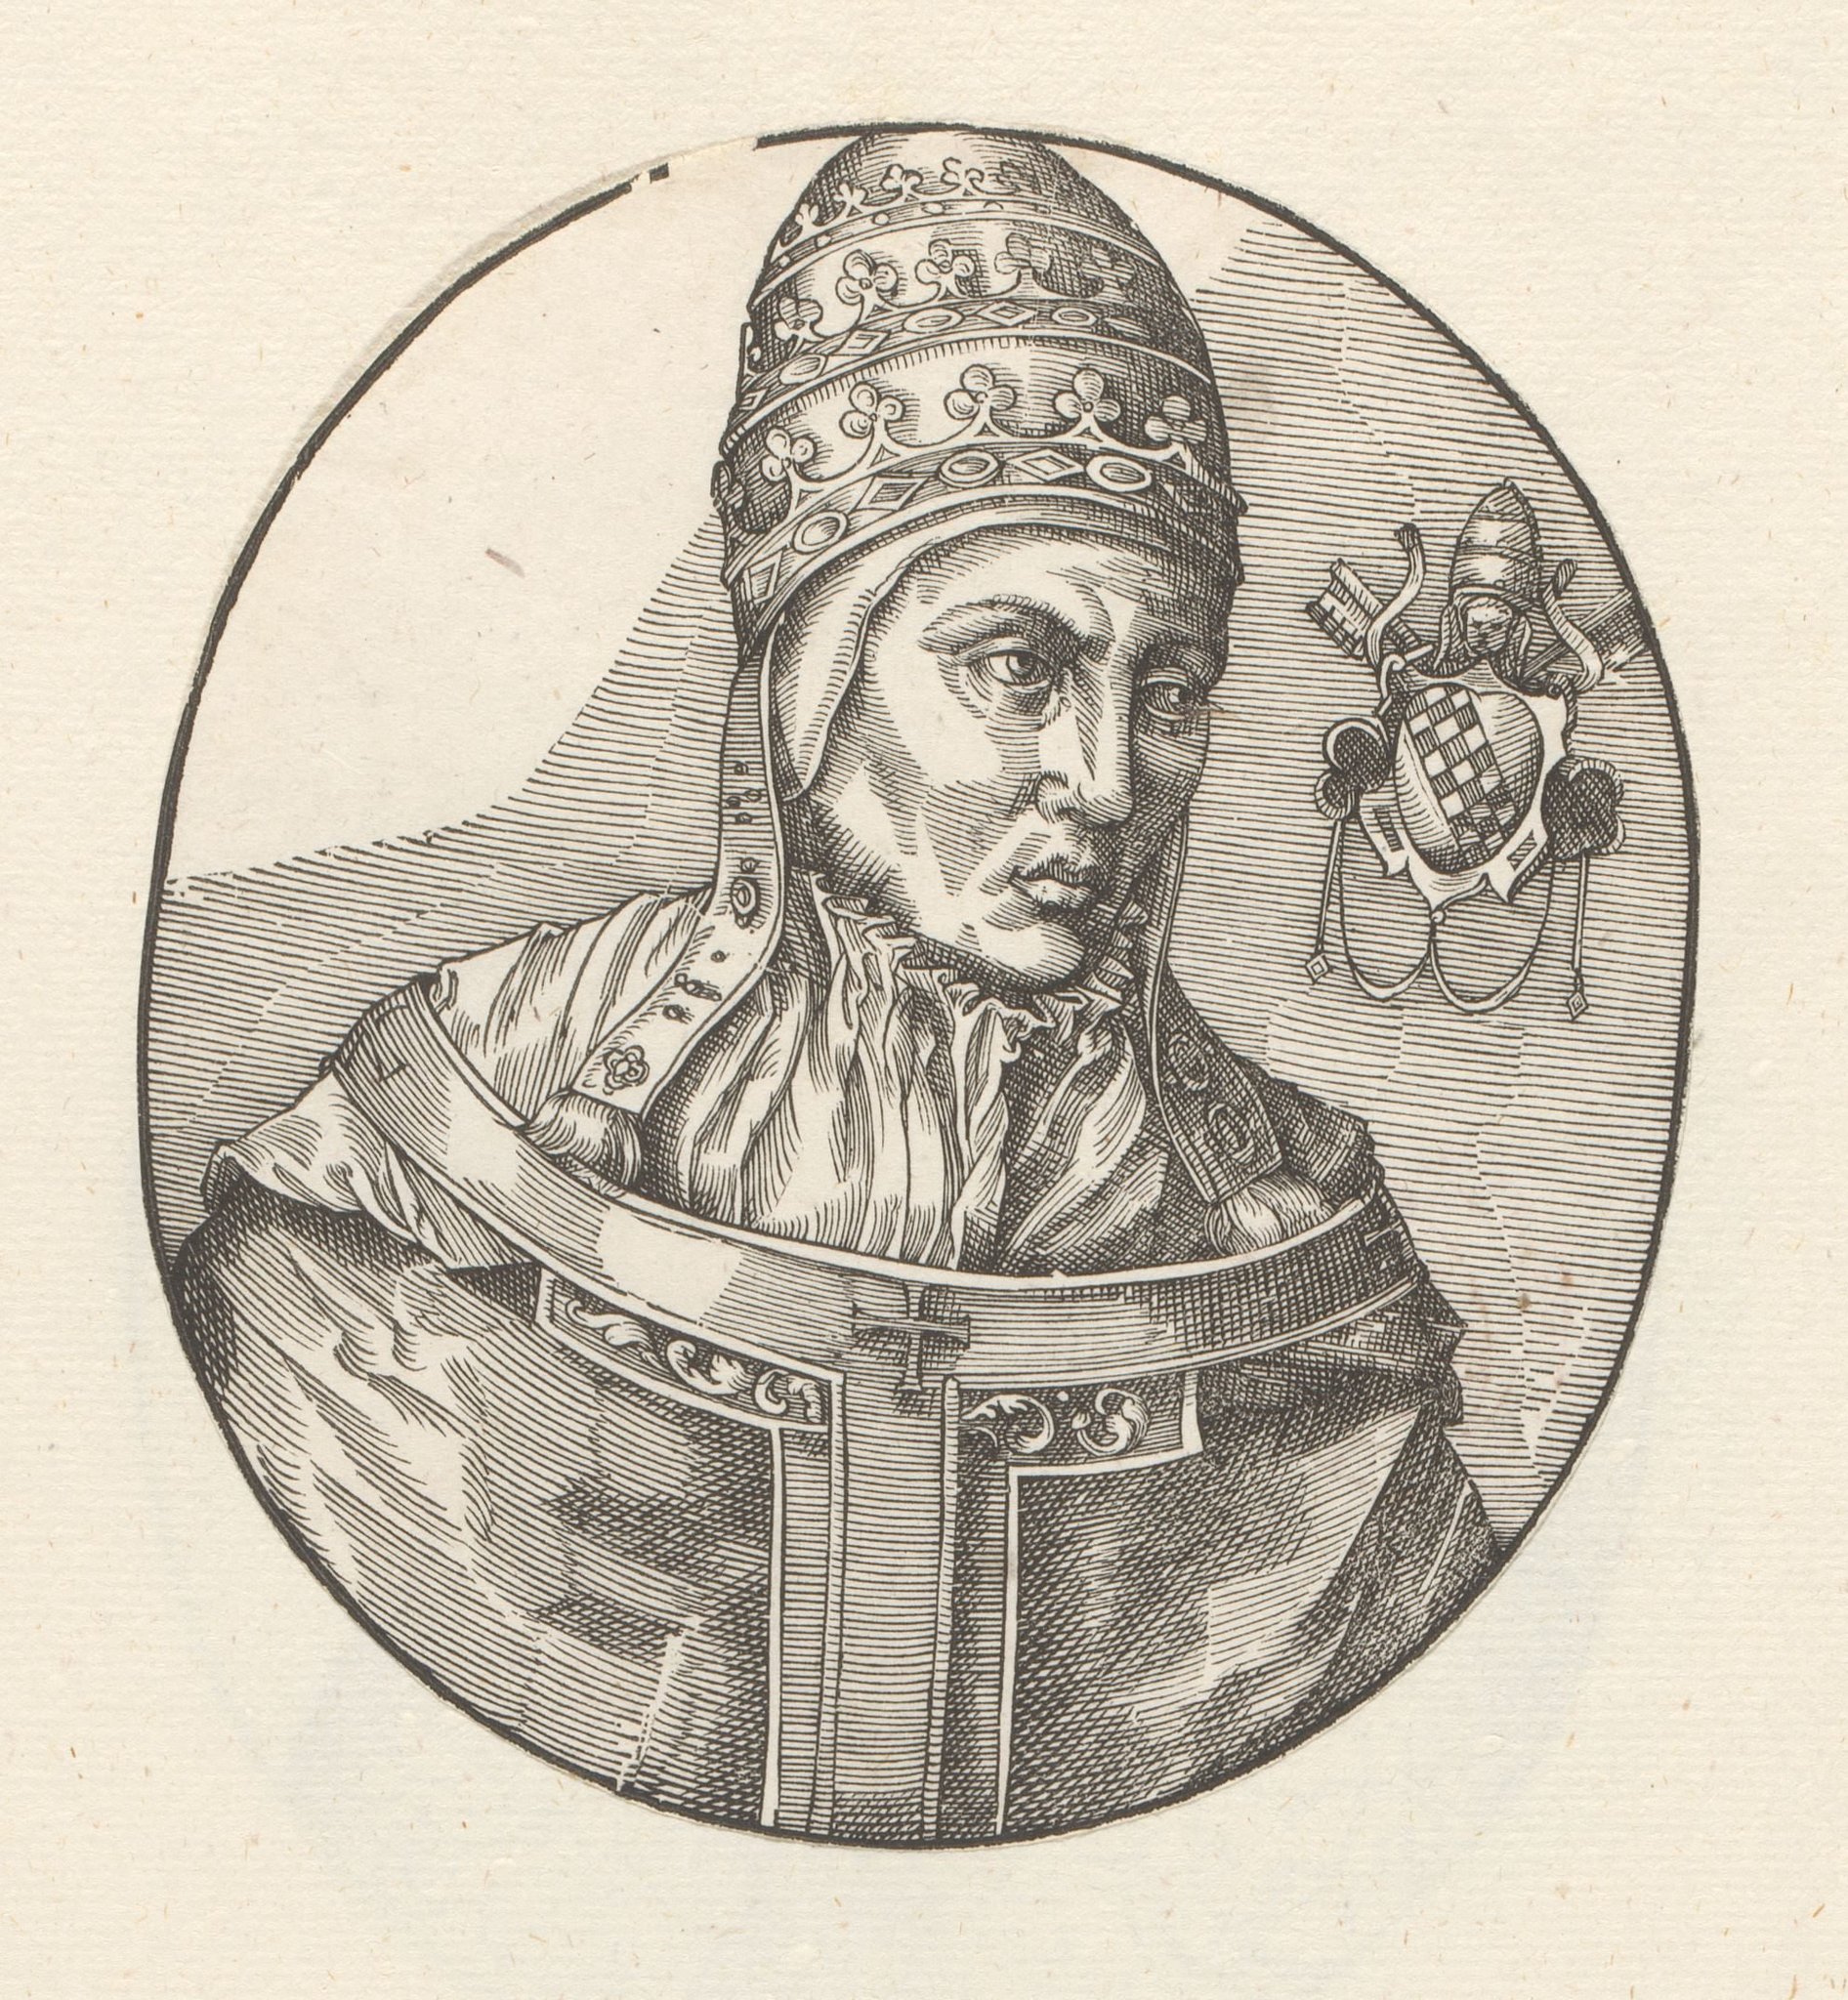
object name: print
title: Portret van paus Bonifatius IX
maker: Anonymous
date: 1549-1573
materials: paper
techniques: woodcut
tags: rome, historical persons, pope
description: Prent gebruikt in: Panvinio, Onofrio. Accuratae Effigies Pontificum (...). Straatsburg: Bernhard Jobin, 1573.